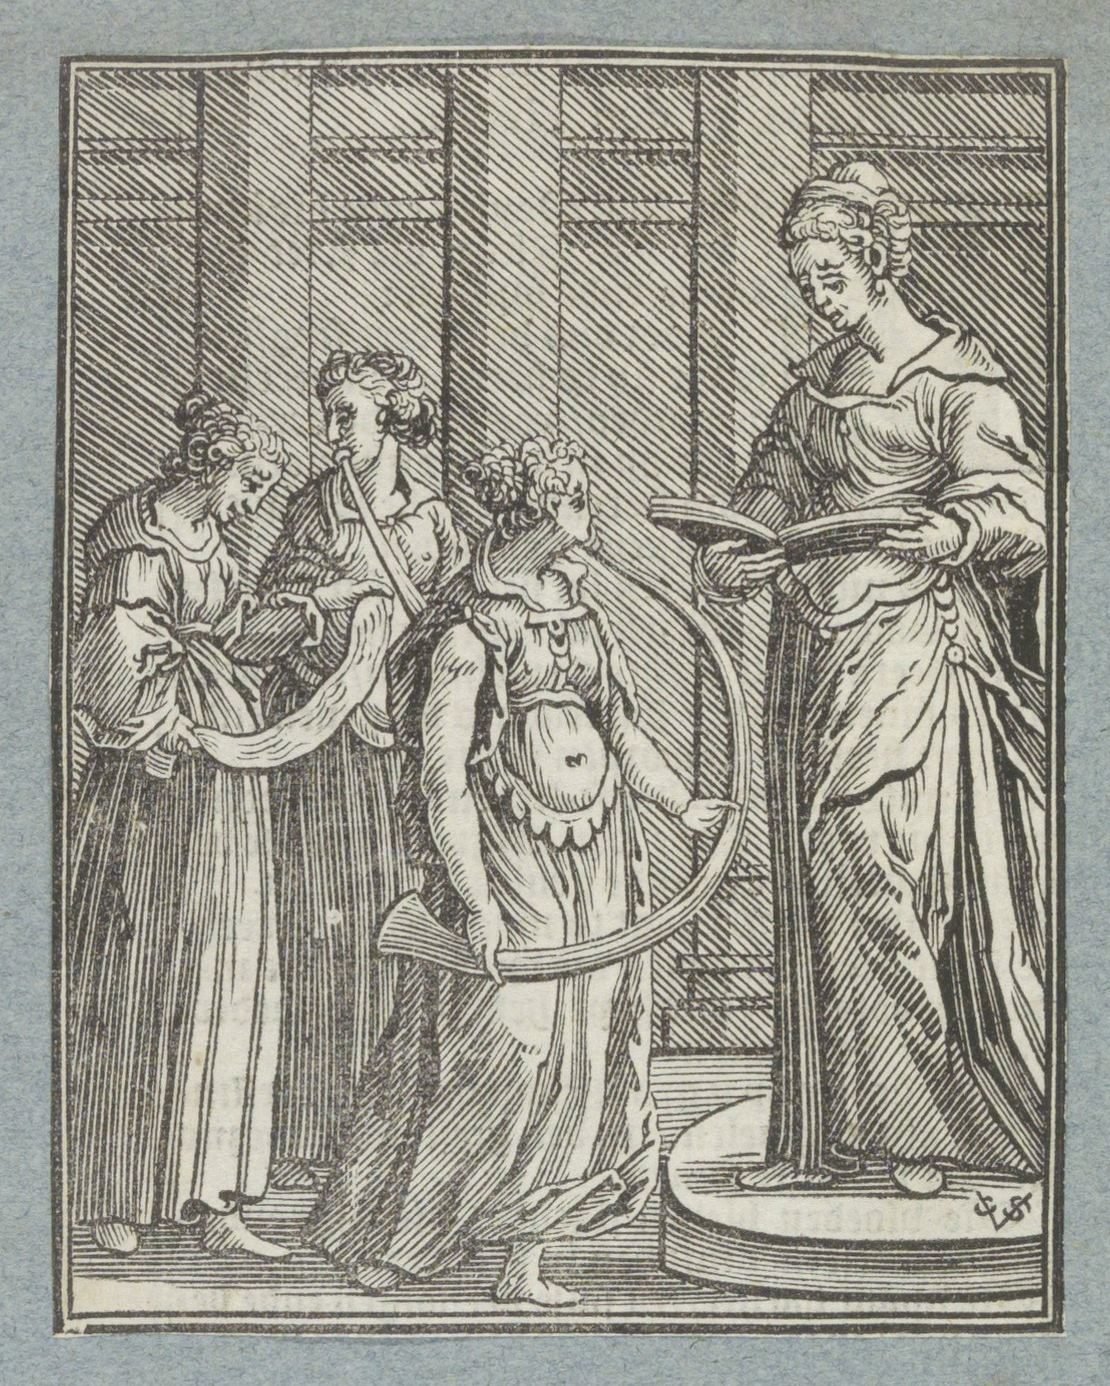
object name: album leaf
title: Mirjams danklied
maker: pieter jacobsz. paets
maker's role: publisher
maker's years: 1587-1667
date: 1645-1646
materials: paper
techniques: letterpress printing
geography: amsterdam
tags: making music; musician with instrument, miriam's song of praise ~ exodus, vocal music, singing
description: Zingende en musicerende vrouwen. Hier gebruikt als afbeelding van de profetes Mirjam, Aärons zuster, die een danklied zingt. De drie andere vrouwen hebben een boekrol of een muziekinstrument in hun handen. De prent maakt deel uit van een album.